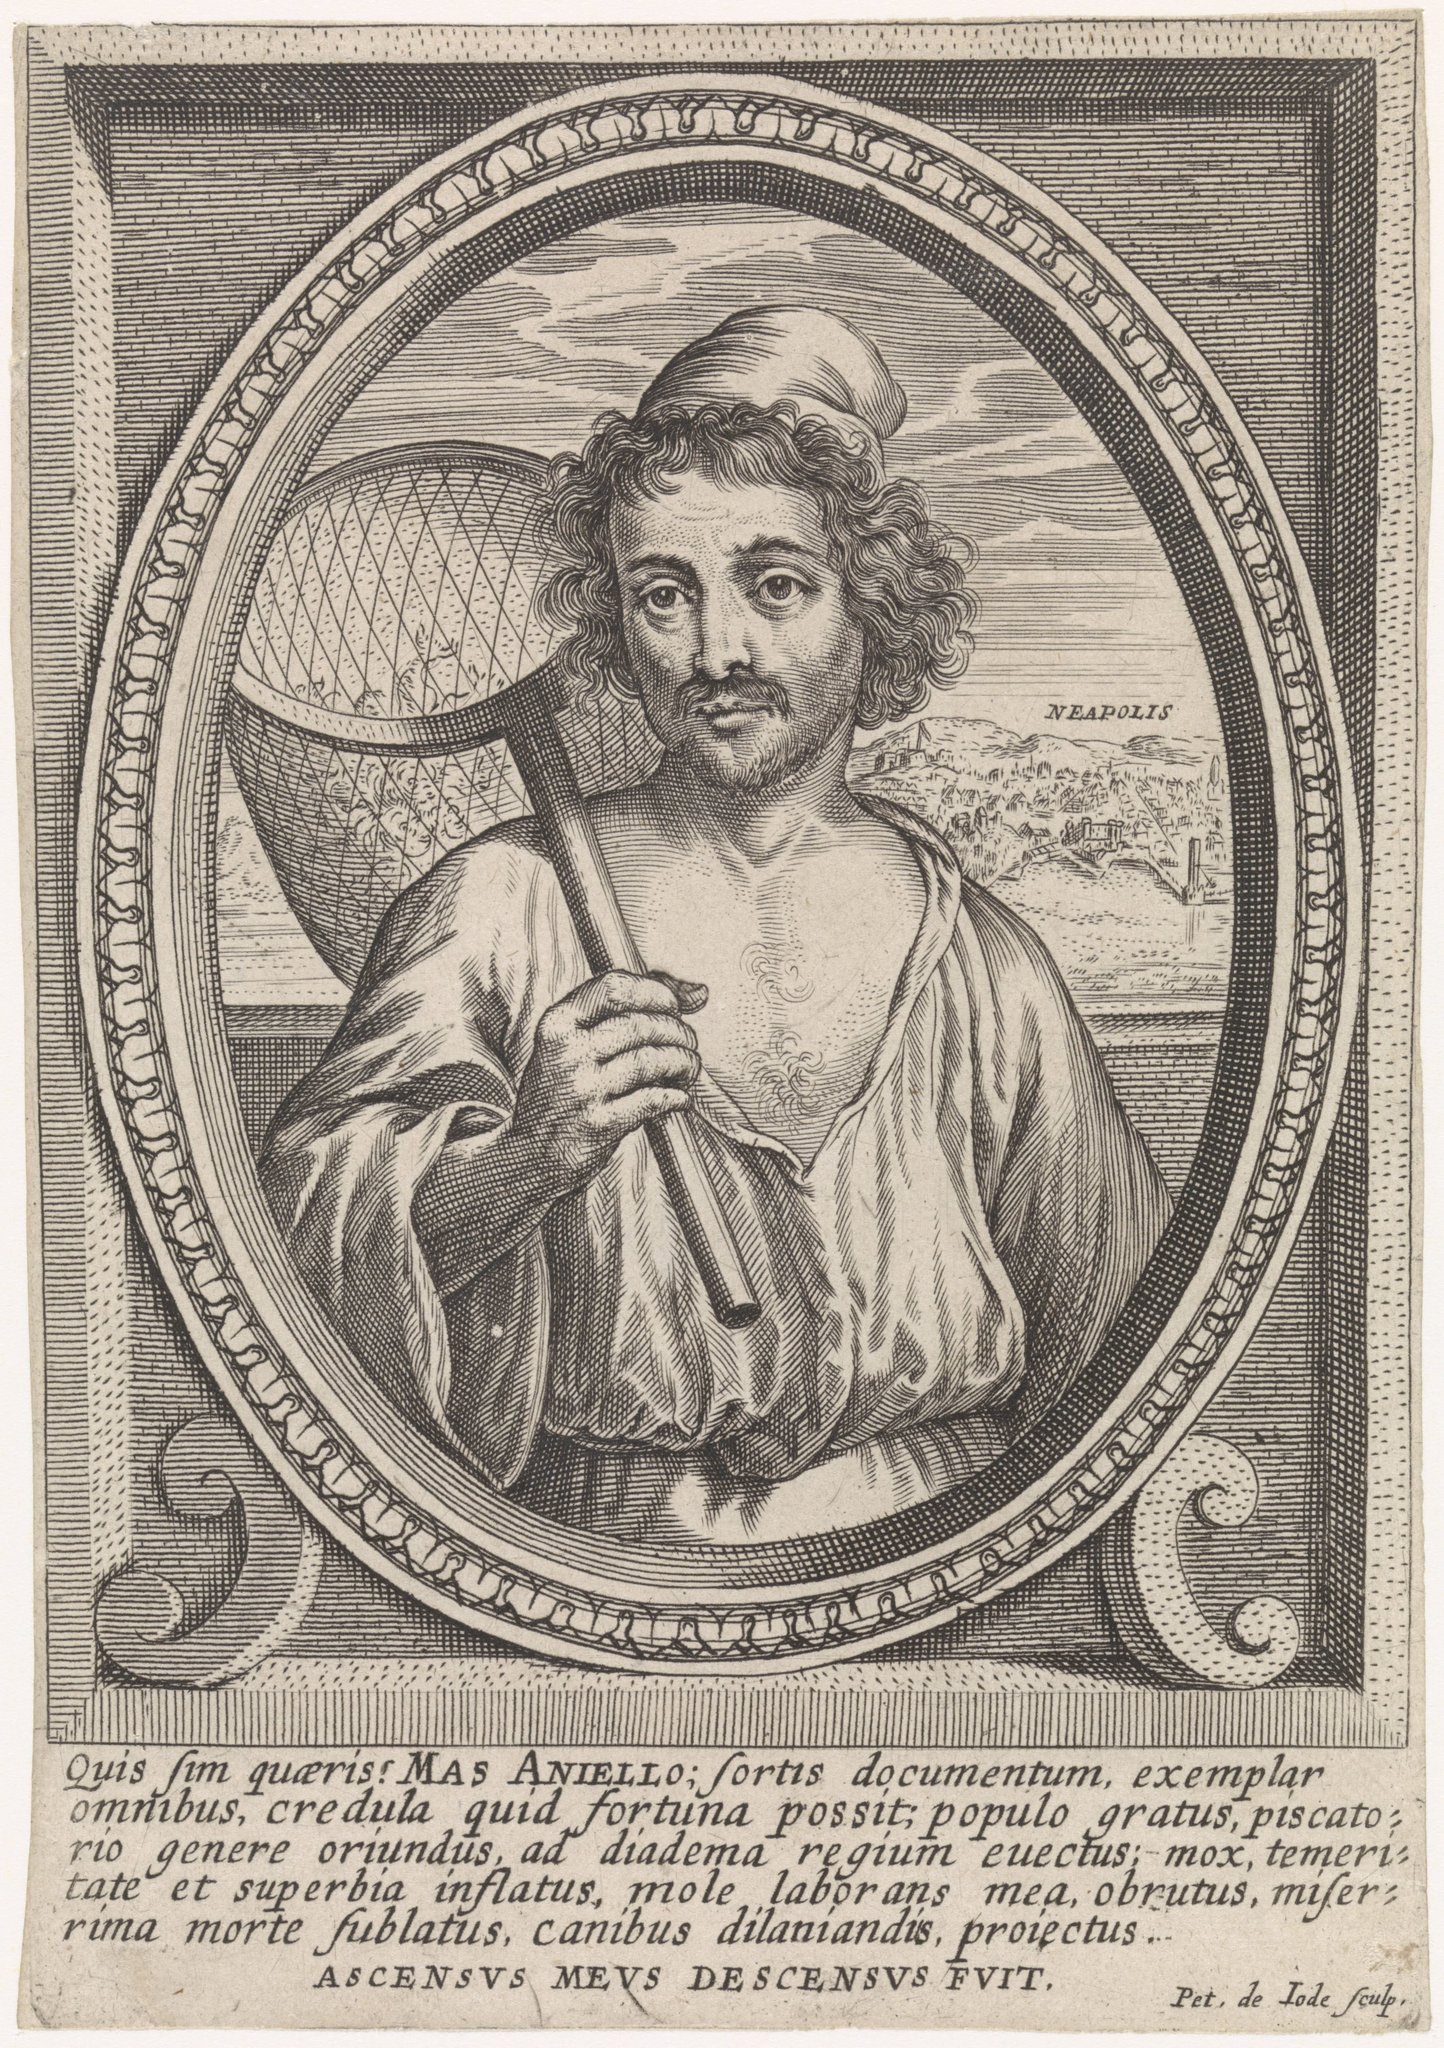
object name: print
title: Portret van Tommaso Aniello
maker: pieter de jode (ii)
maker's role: draughtsman, print maker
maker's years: 1606-1674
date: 1628-1670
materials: paper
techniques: engraving, etching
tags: amalfi, naples, fisherman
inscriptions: collector's mark: Lugt 2228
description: Portret van Tommaso Aniello, met vissersnet. Op de achtergrond een gezicht op Napels. Het portret is gevat in een omlijsting. In de marge een vijfregelig onderschrift in het Latijn.